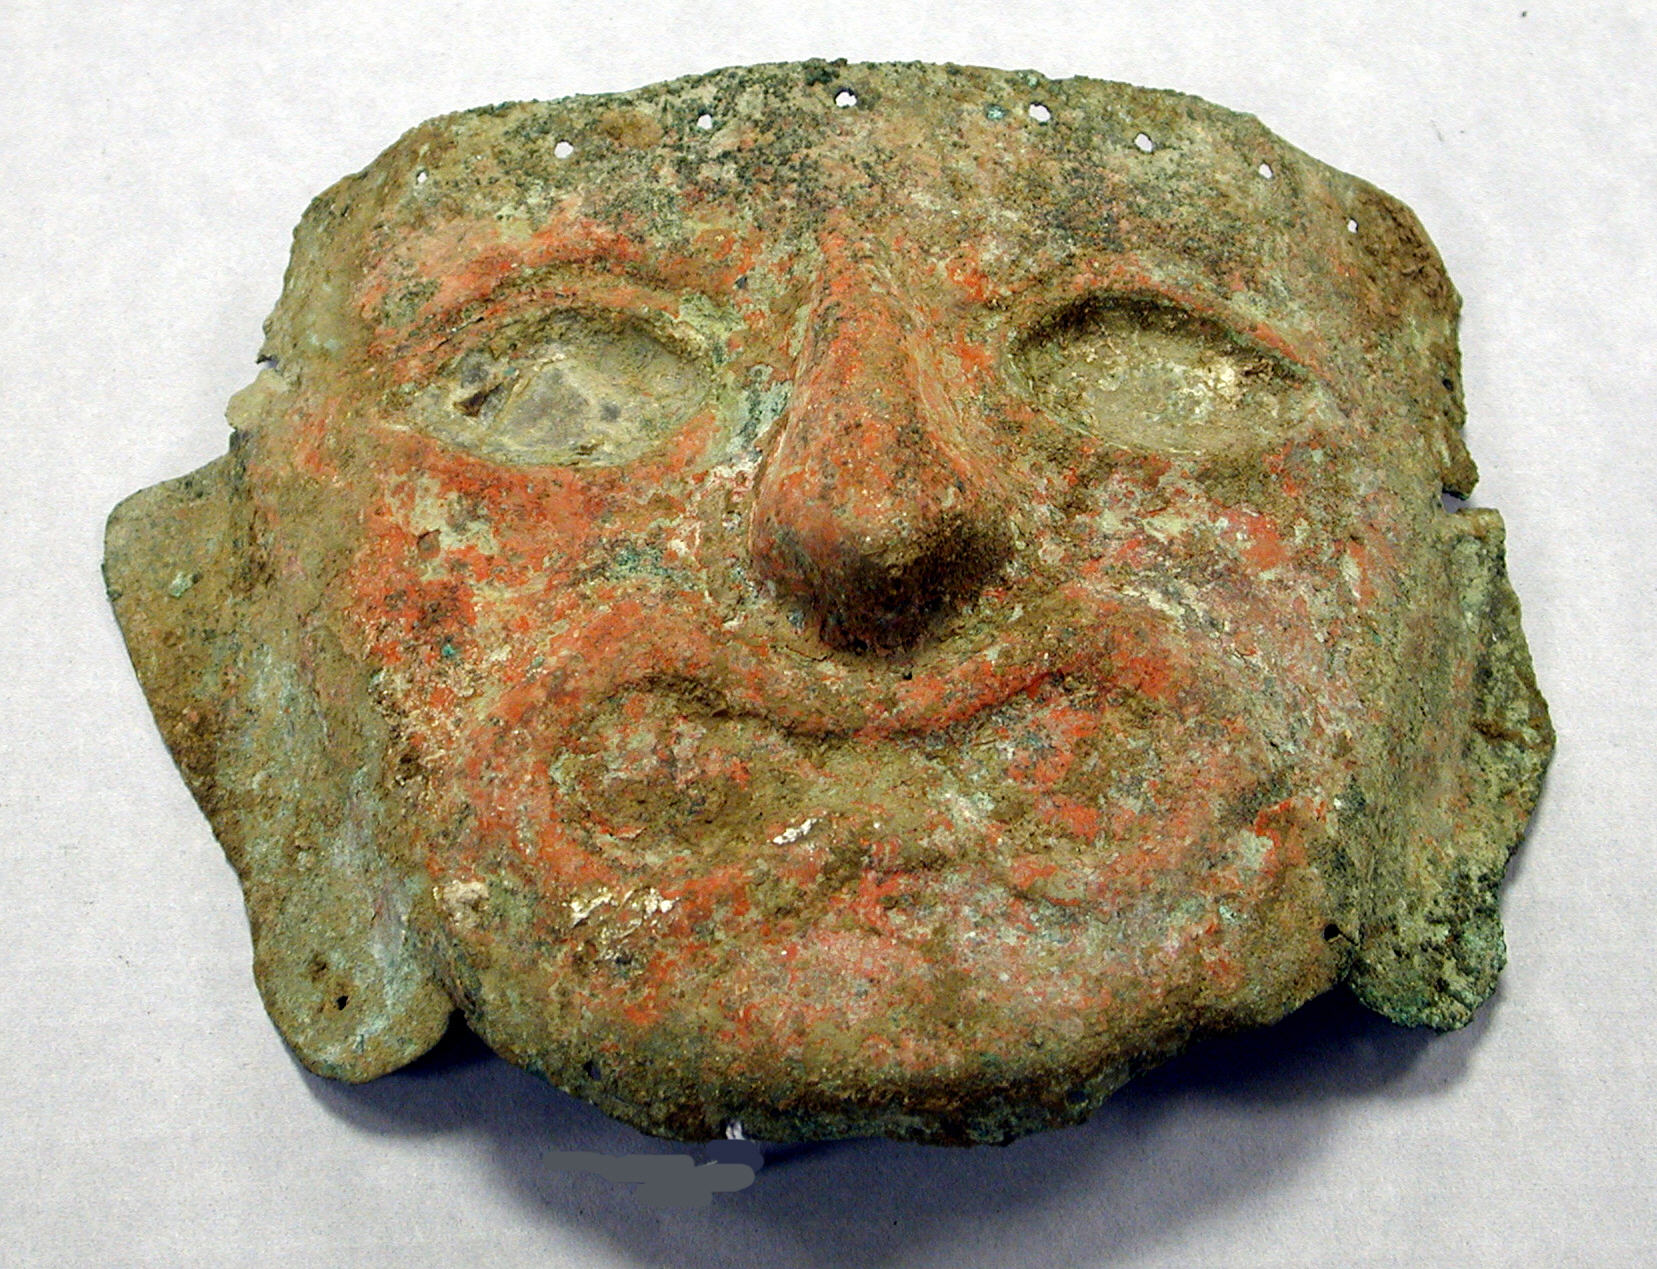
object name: mask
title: Face Mask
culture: moche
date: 101-700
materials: copper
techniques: hammering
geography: peru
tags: faces